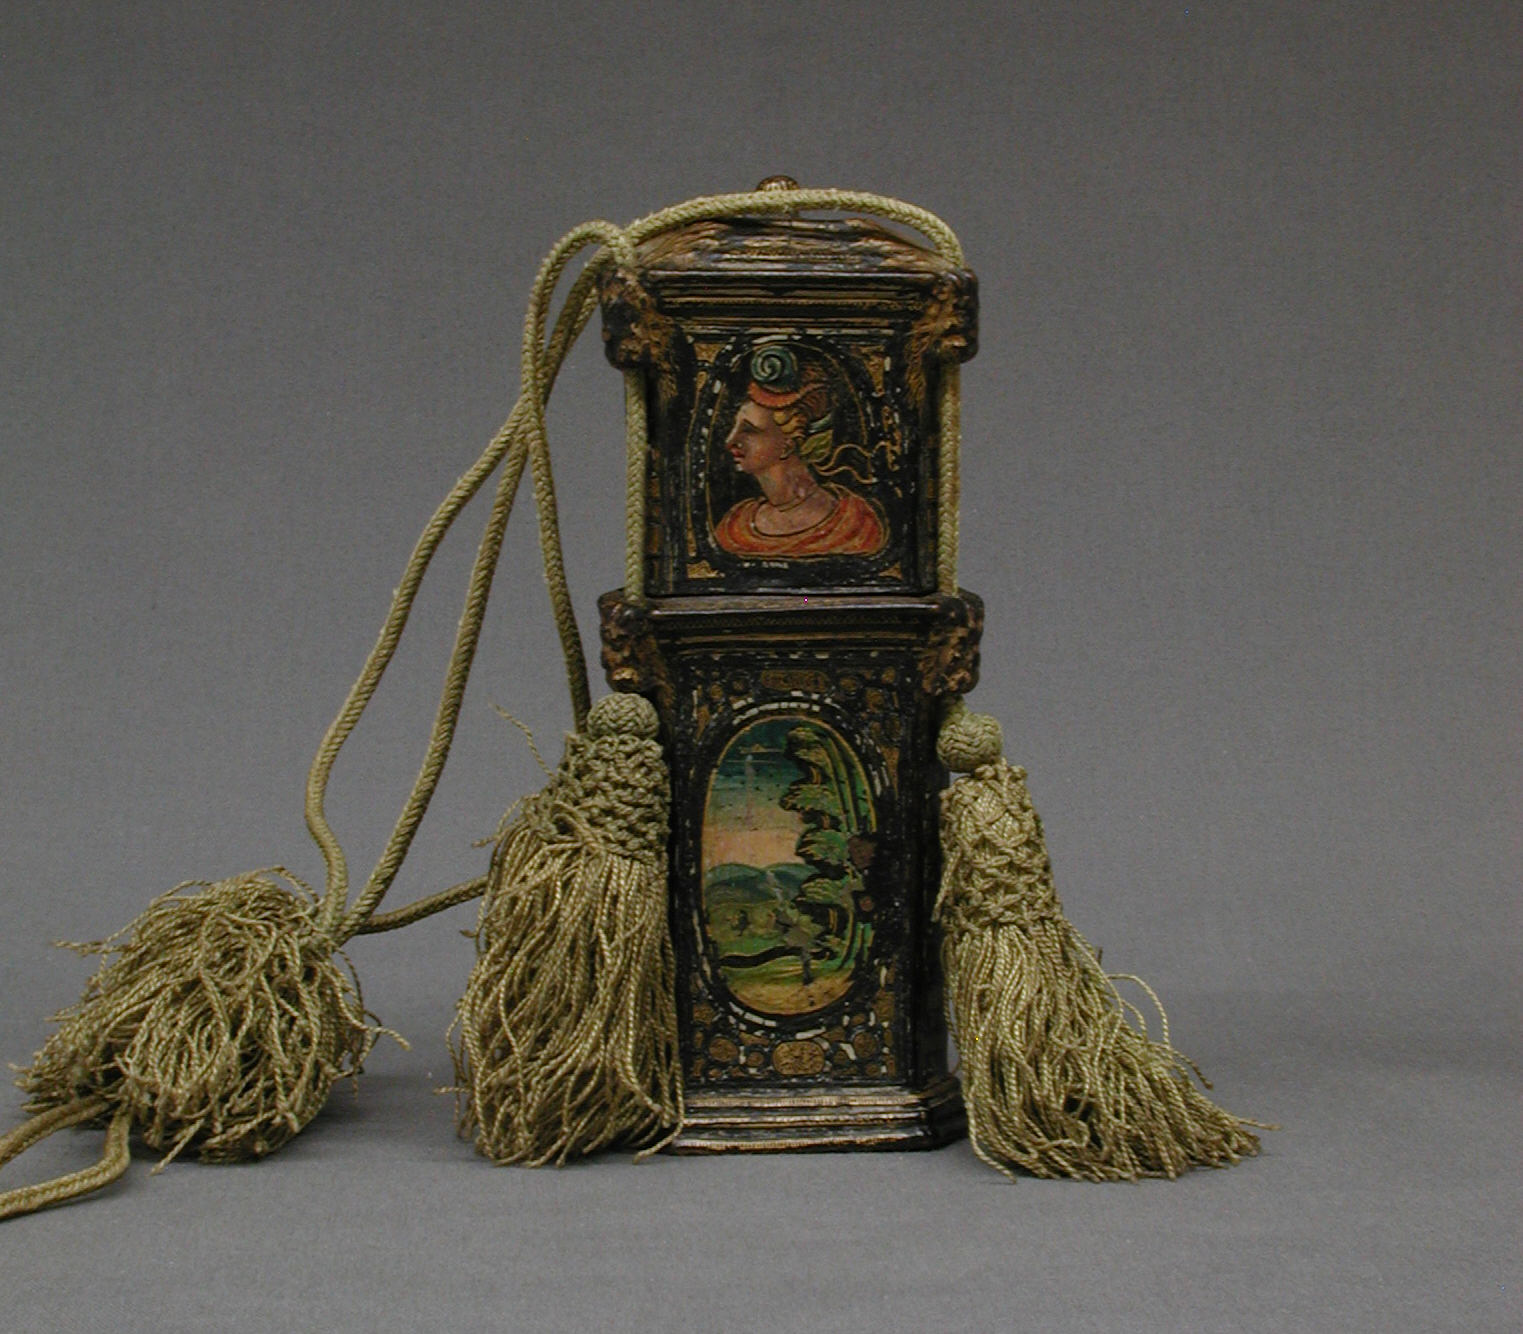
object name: case with toilet accessory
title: Case containing toilet accessories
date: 1501-1600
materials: leather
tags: human figures,profiles,trees